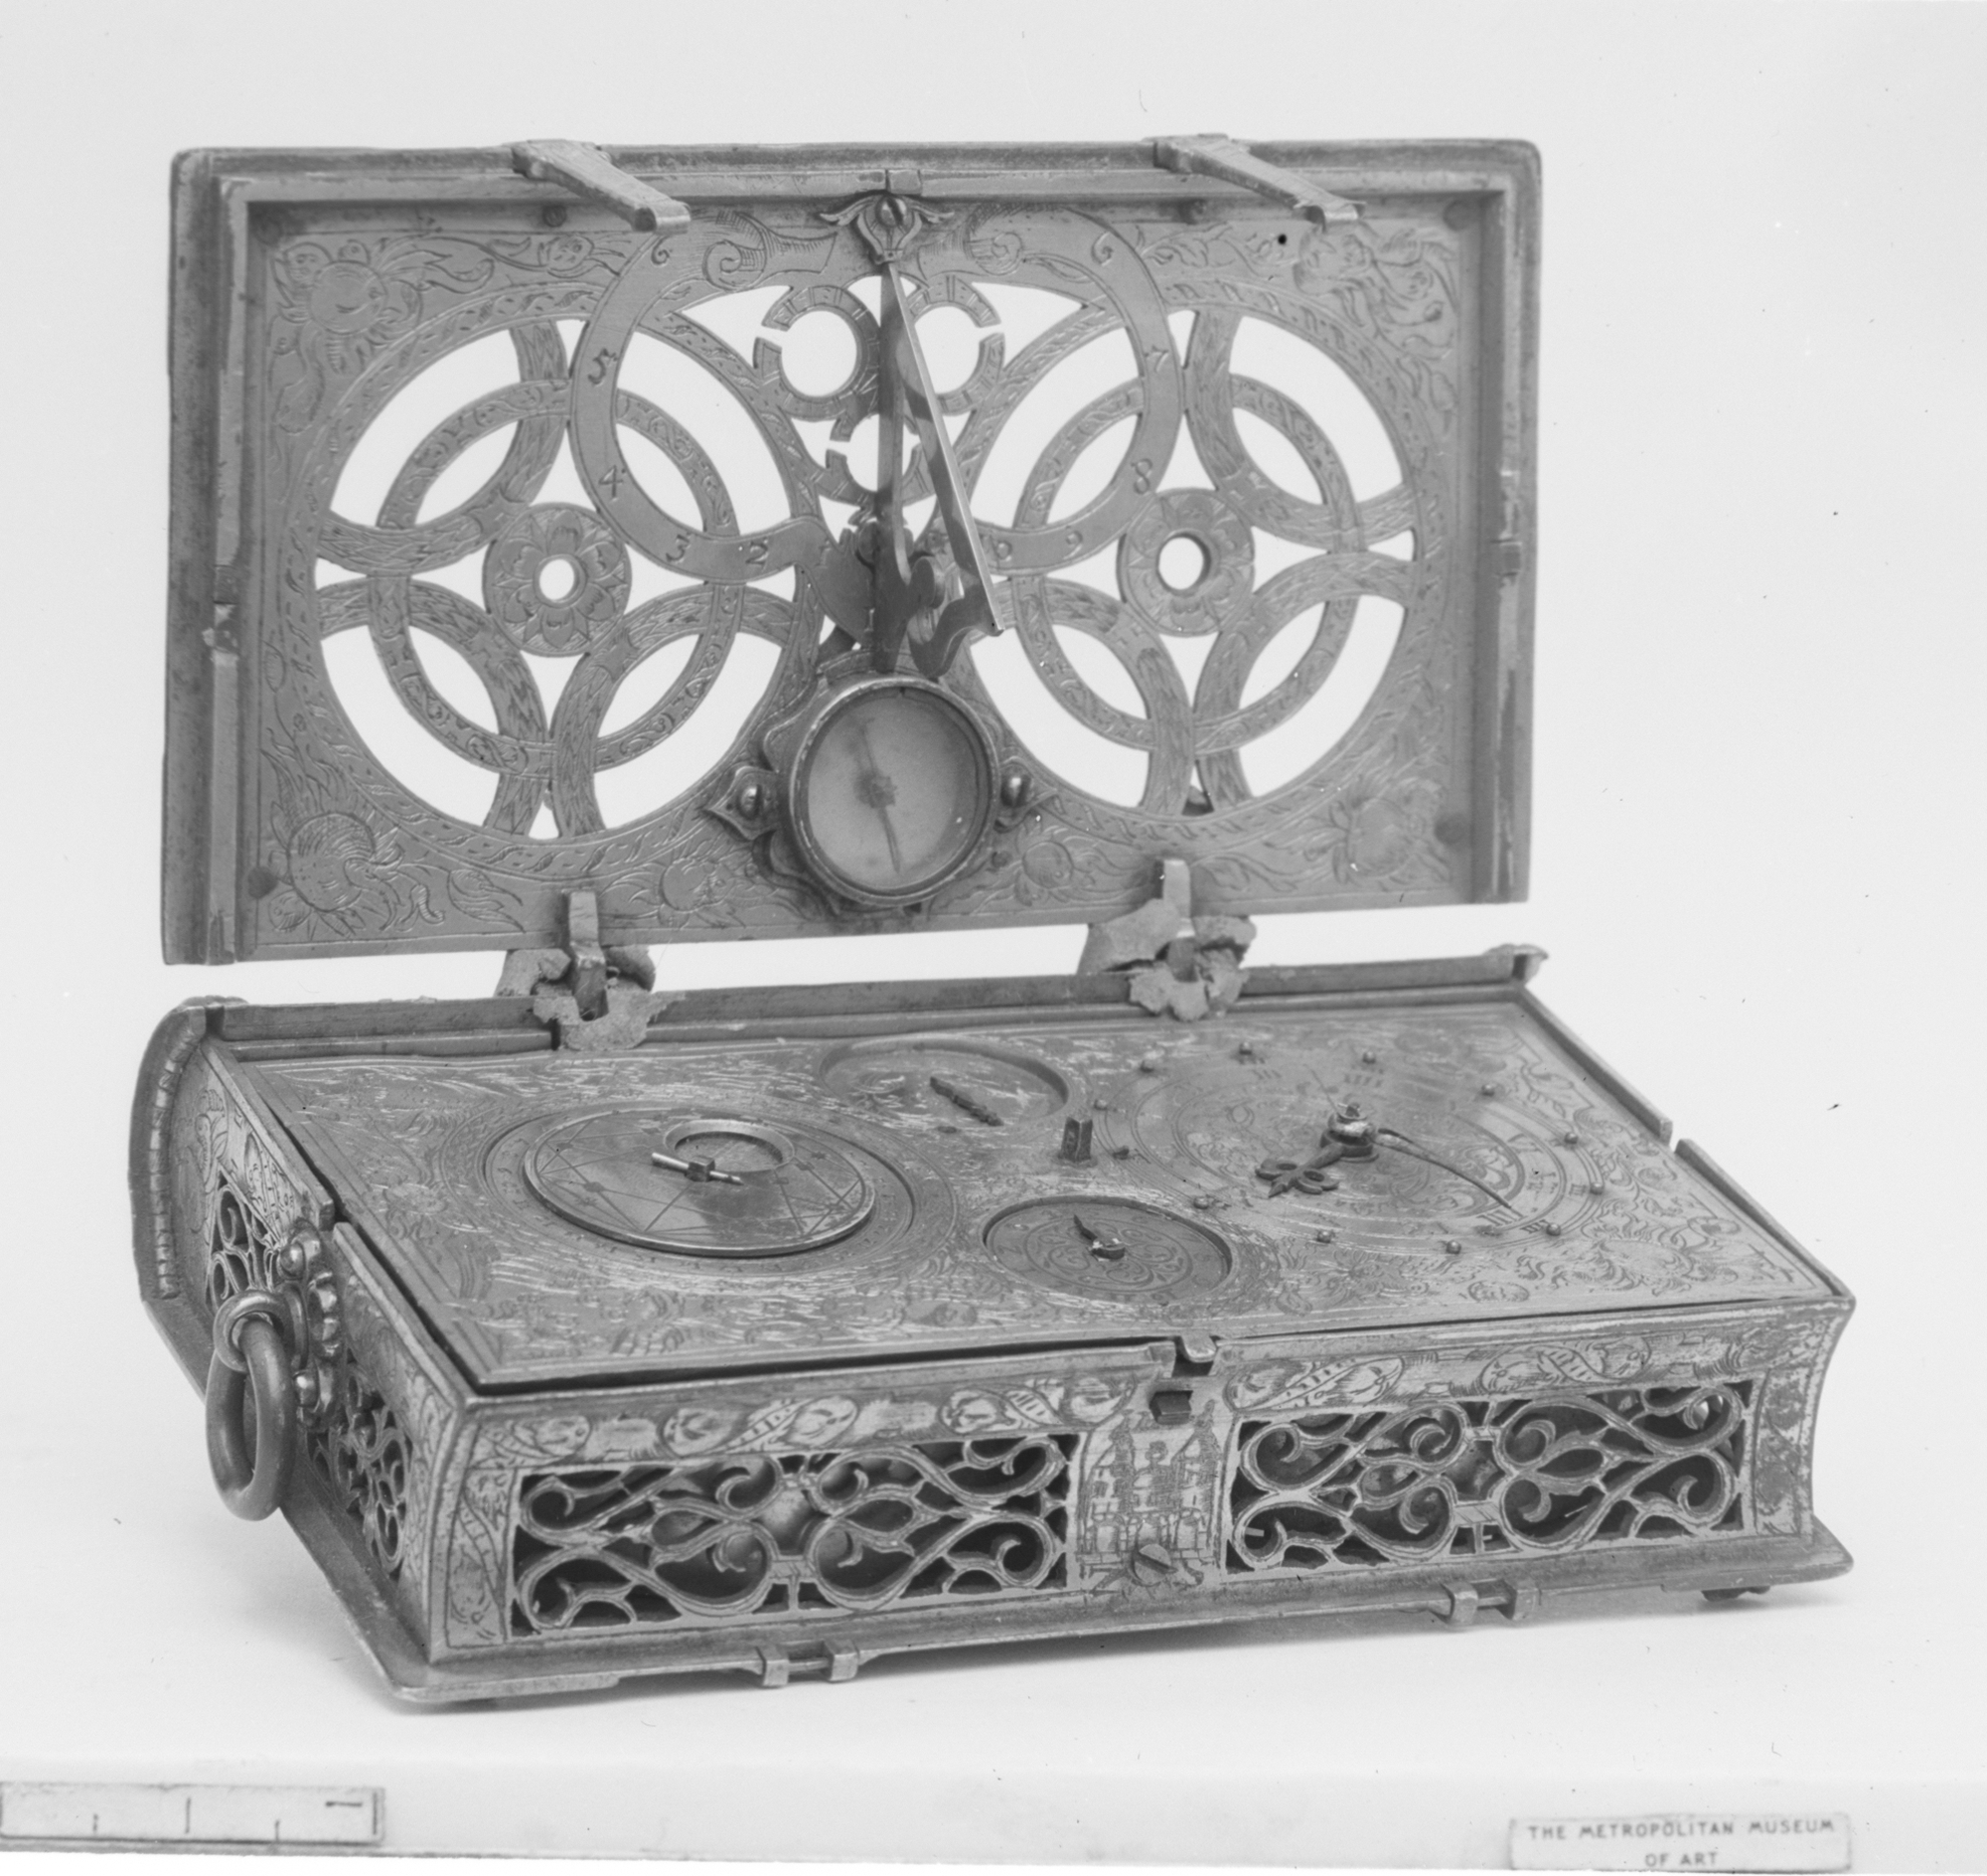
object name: astronomical watch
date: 1580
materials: gilt, metal